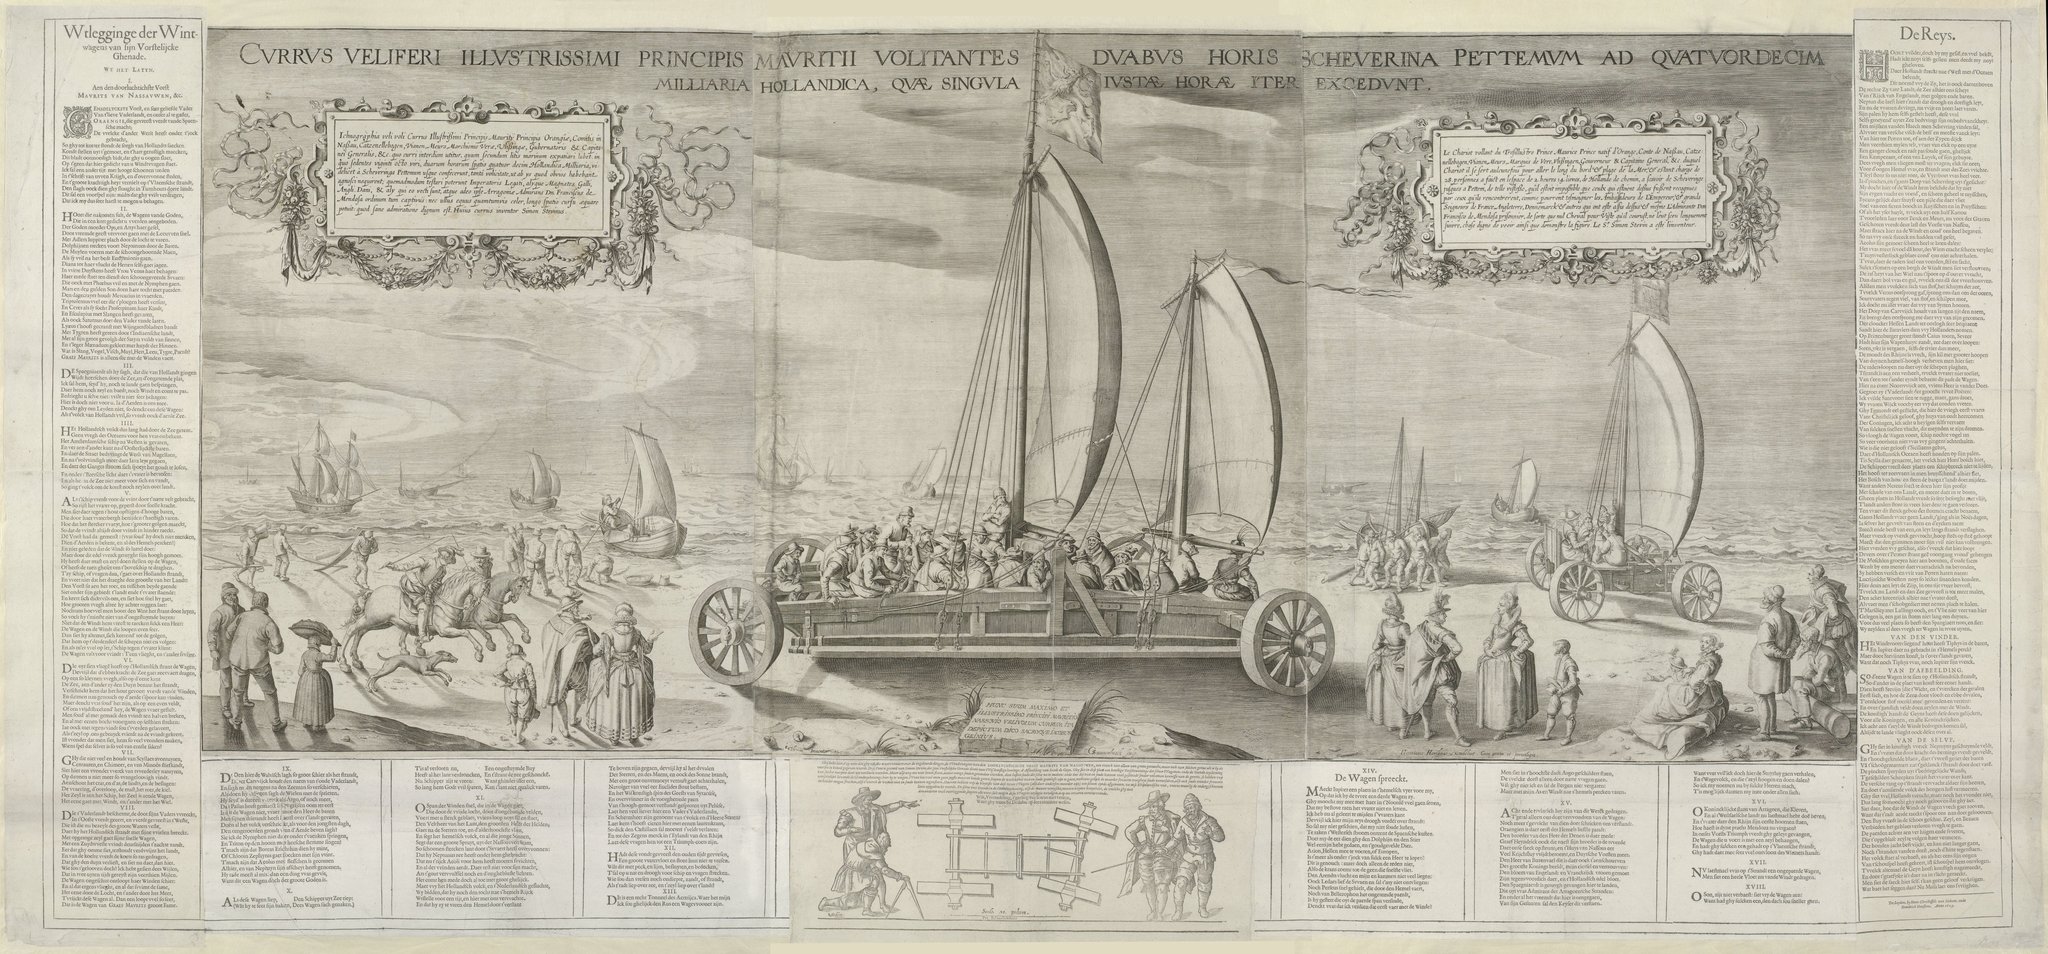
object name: print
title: De zeilwagen van Simon Stevin, 1602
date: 1603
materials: paper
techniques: engraving, letterpress printing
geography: amsterdam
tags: the hague, maurice (prince of orange), bruges, simon stevin, sailing-car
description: De zeilwagen van Simon Stevin, 1602. Prins Maurits maakt samen met een groep vrienden een tocht over het strand van Scheveningen naar Petten in de zeilwagen gebouwd door Simon Stevin, april-mei 1602. In het midden zit de prins tussen zijn vrienden in de grote wagen. Daaronder een stenen tablet met opschrift in het Latijn (de opdracht). Rechts en kleine zeilwagen, waarschijnlijk een prototype, met enkele personen aan boord. Op het strand toeschouwers, vissers en twee ruiters. Linksboven een cartouche ingevuld met tekst in het Latijn. Rechtsboven een cartouche ingevuld met tekst in het Frans. Onderaan een houtsnede met enkele figuren en een schematische voorstelling van de zeilwagen. Samengesteld geheel van drie platen en meerdere tekstbladen, gemonteerd en ingelijst.